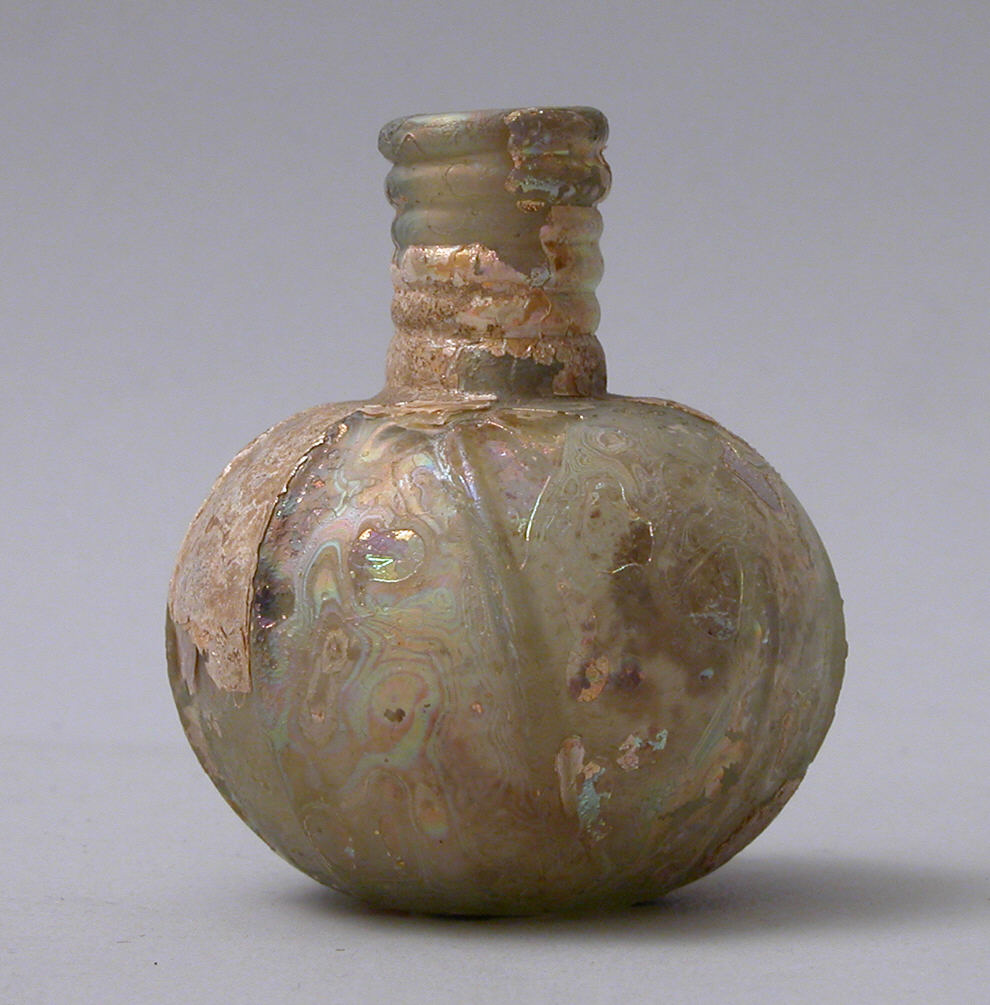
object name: bottle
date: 601-700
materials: glass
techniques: glassblowing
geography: syria